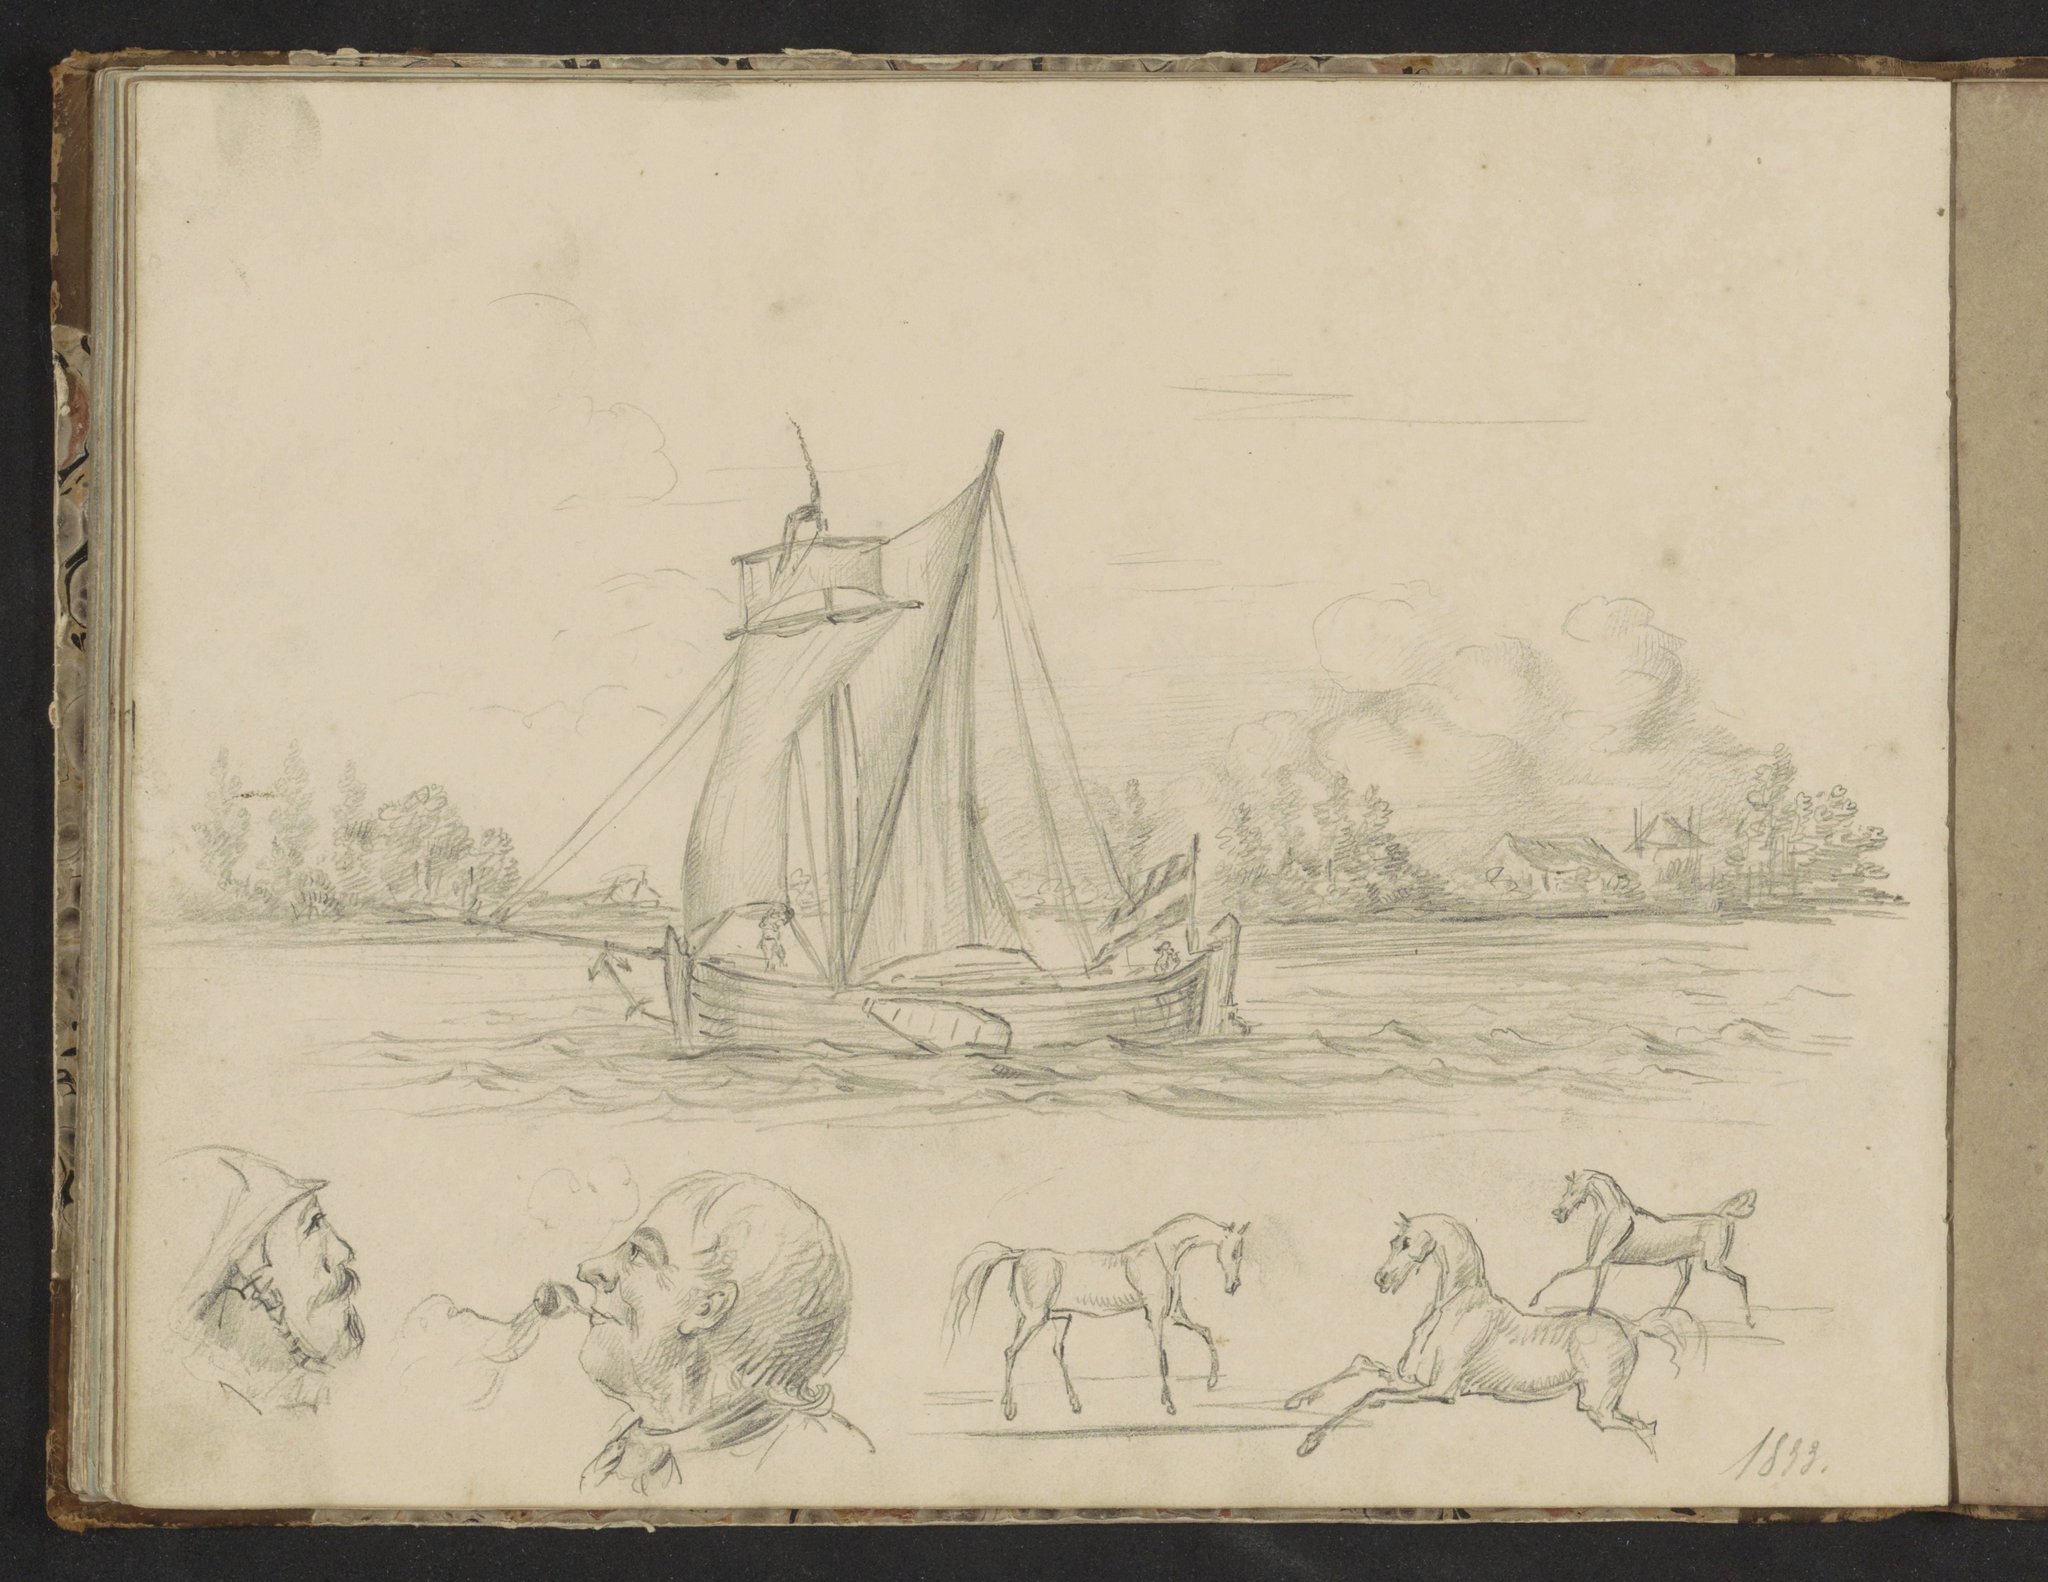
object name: sketchbook leaf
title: Zeilschip op een rivier, vermoedelijk de IJssel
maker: johannes tavenraat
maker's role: draughtsman, painter, print maker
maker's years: 1809-1881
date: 1833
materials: paper, pencil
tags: head (human), sailing-ship, sailing-boat, river, adult man, horse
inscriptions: date: ‘1833.’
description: Tevens studies van mannenkoppen en paarden. Blad 24 verso uit een schetsboek met 41 bladen.